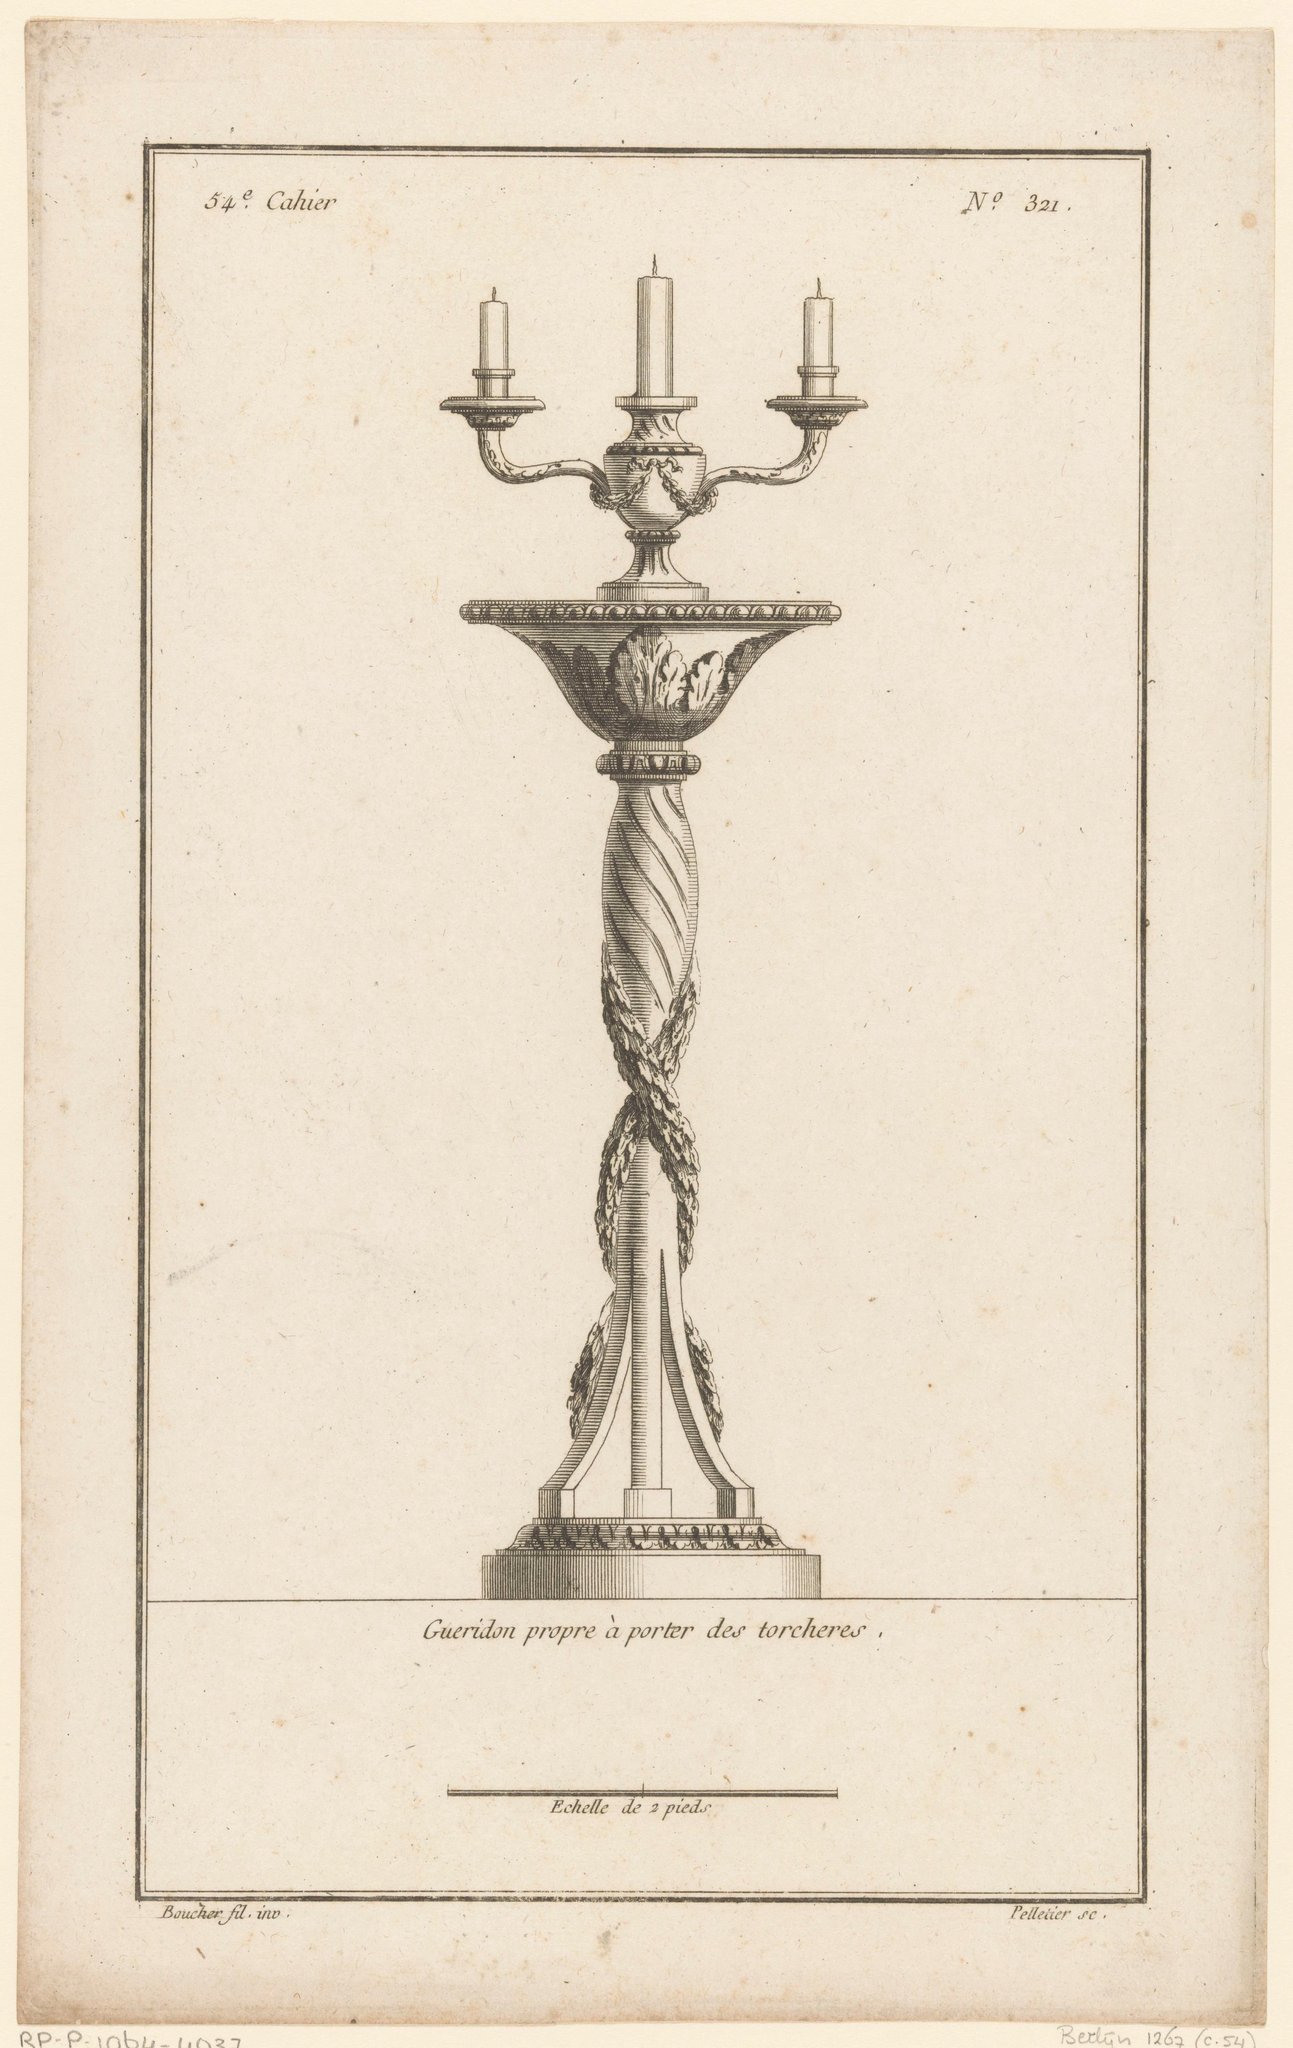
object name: print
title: Gueridon propre à porter des torcheres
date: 1772-1779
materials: paper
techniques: engraving, etching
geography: paris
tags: foliage ~ ornament, chandelier, candelabrum, table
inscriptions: collector's mark: Lugt 2228, collector's mark: Lugt 2760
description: Een gueridon met een driearmige kandelaar en bladmotieven. Prentnummer 321.